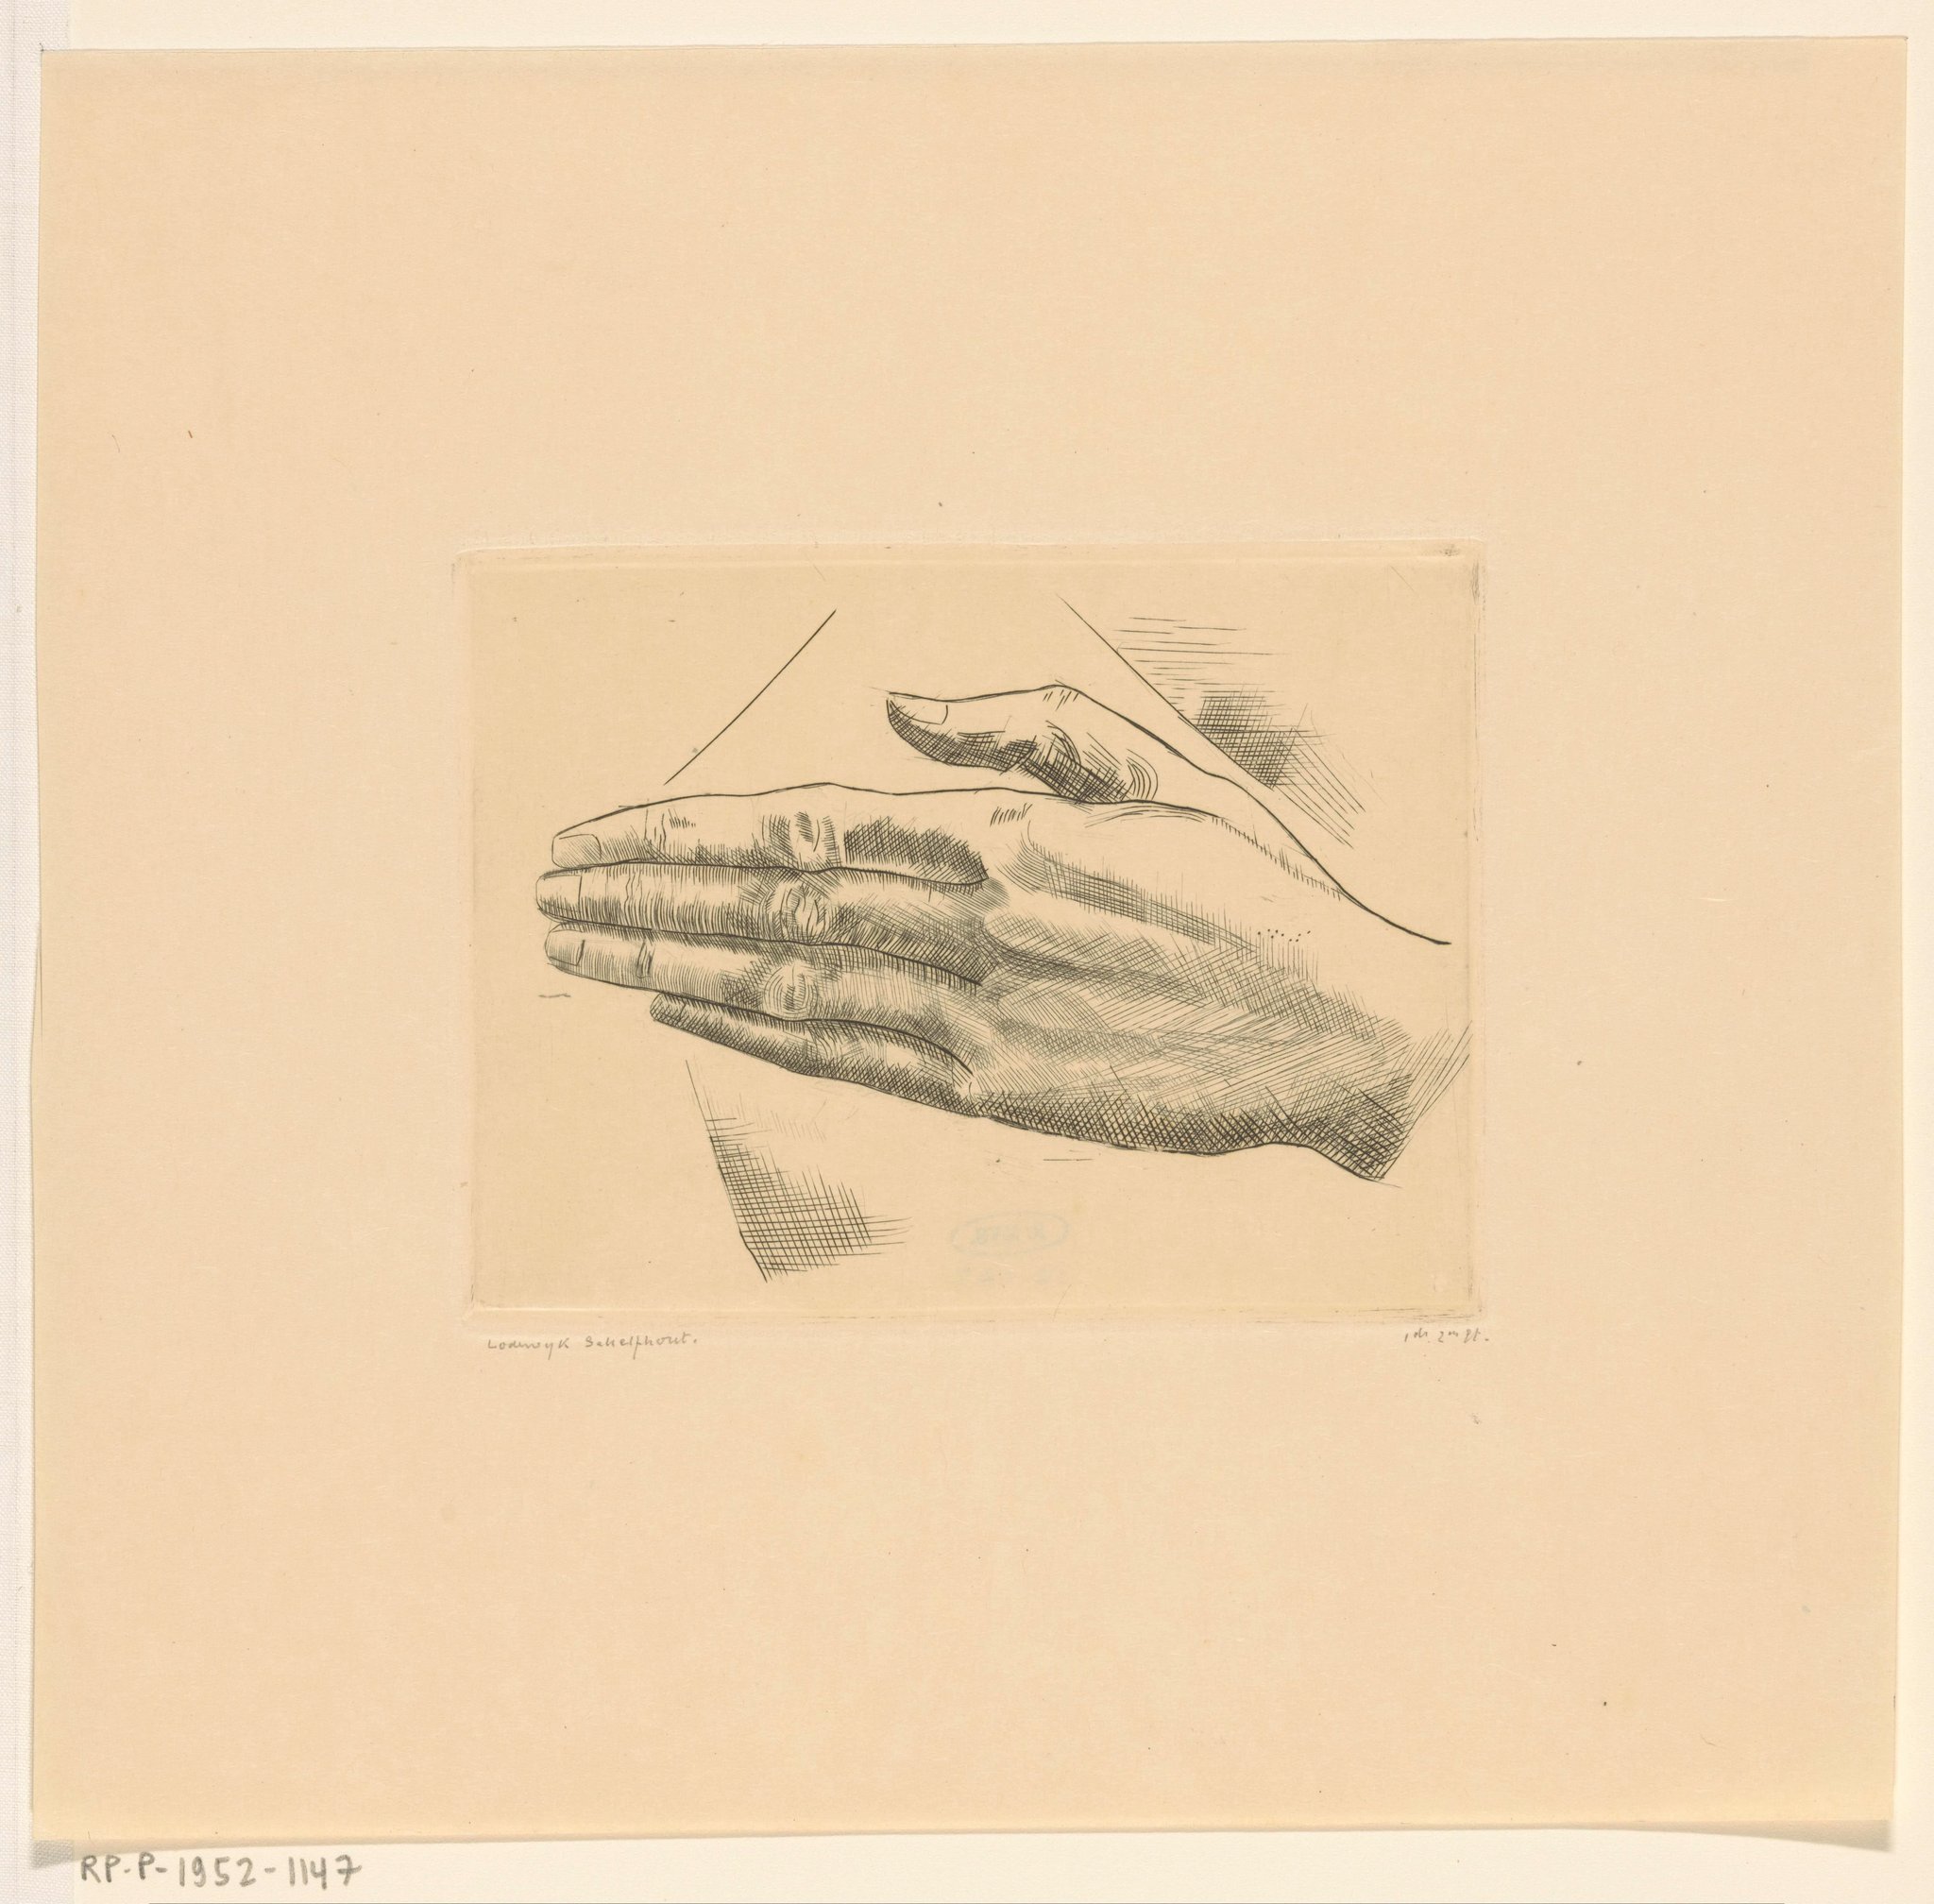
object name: print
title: Hand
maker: lodewijk schelfhout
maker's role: draughtsman, print maker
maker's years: 1881-1943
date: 1932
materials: paper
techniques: drypoint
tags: fingers closed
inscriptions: collector's mark: Lugt 2228